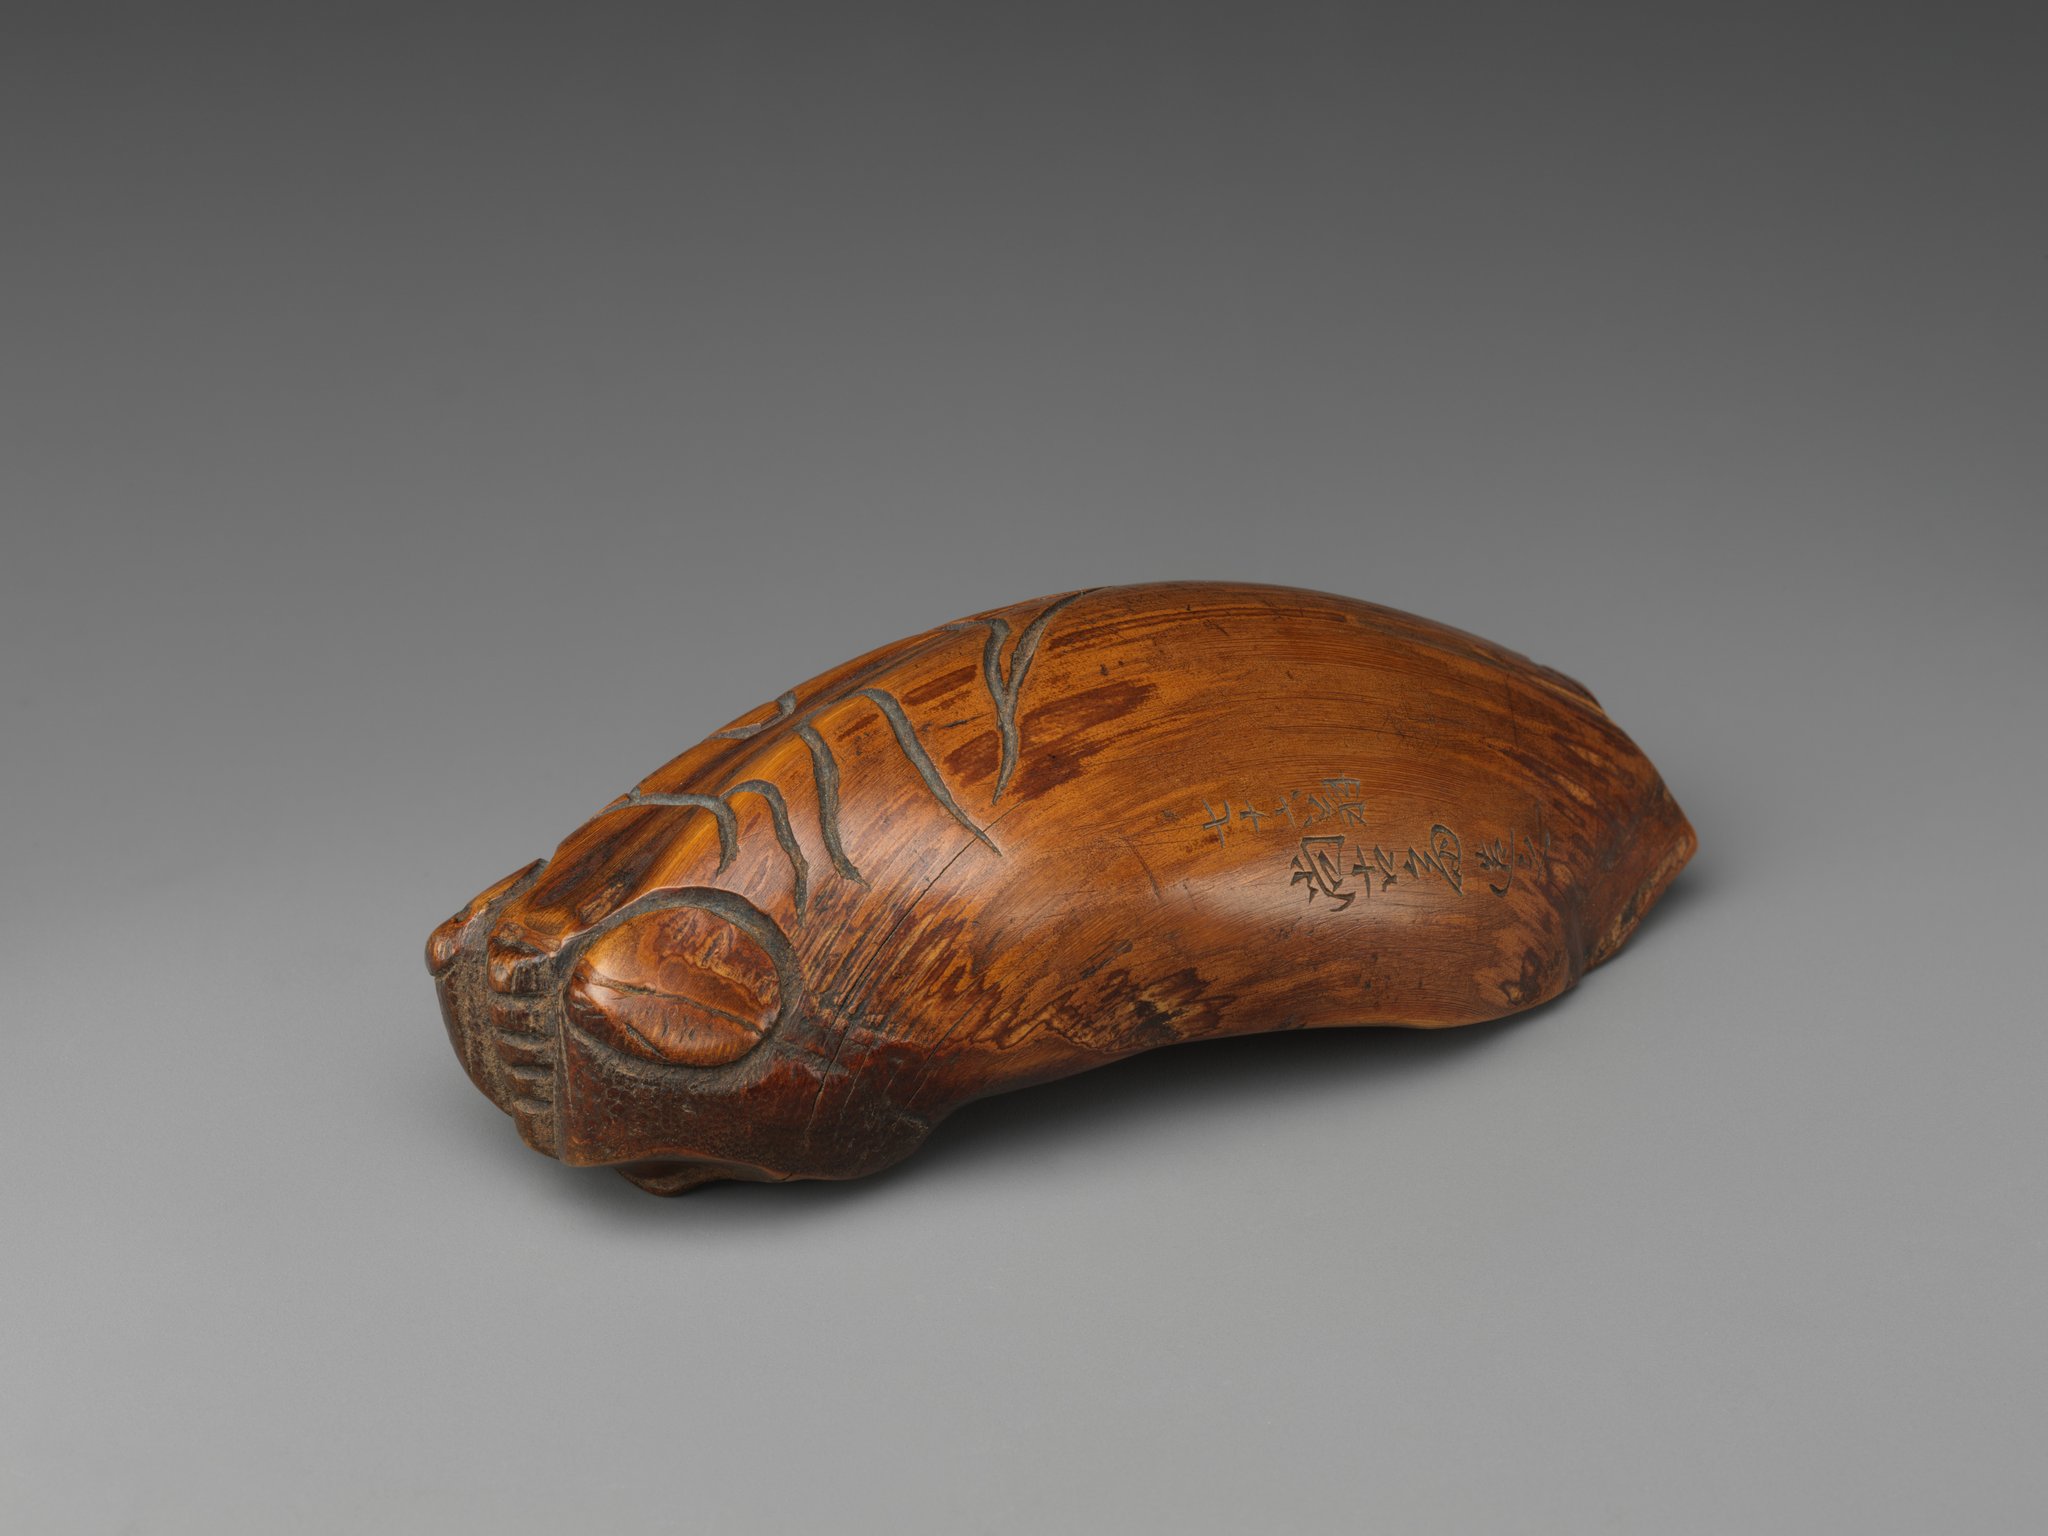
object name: tea scoop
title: Tea Scoop (Chagō) in the Shape of a Cicada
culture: japanese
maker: hayakawa shōkosai i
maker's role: artist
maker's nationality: japanese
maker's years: 1815-1897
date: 1891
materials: bamboo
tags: insects